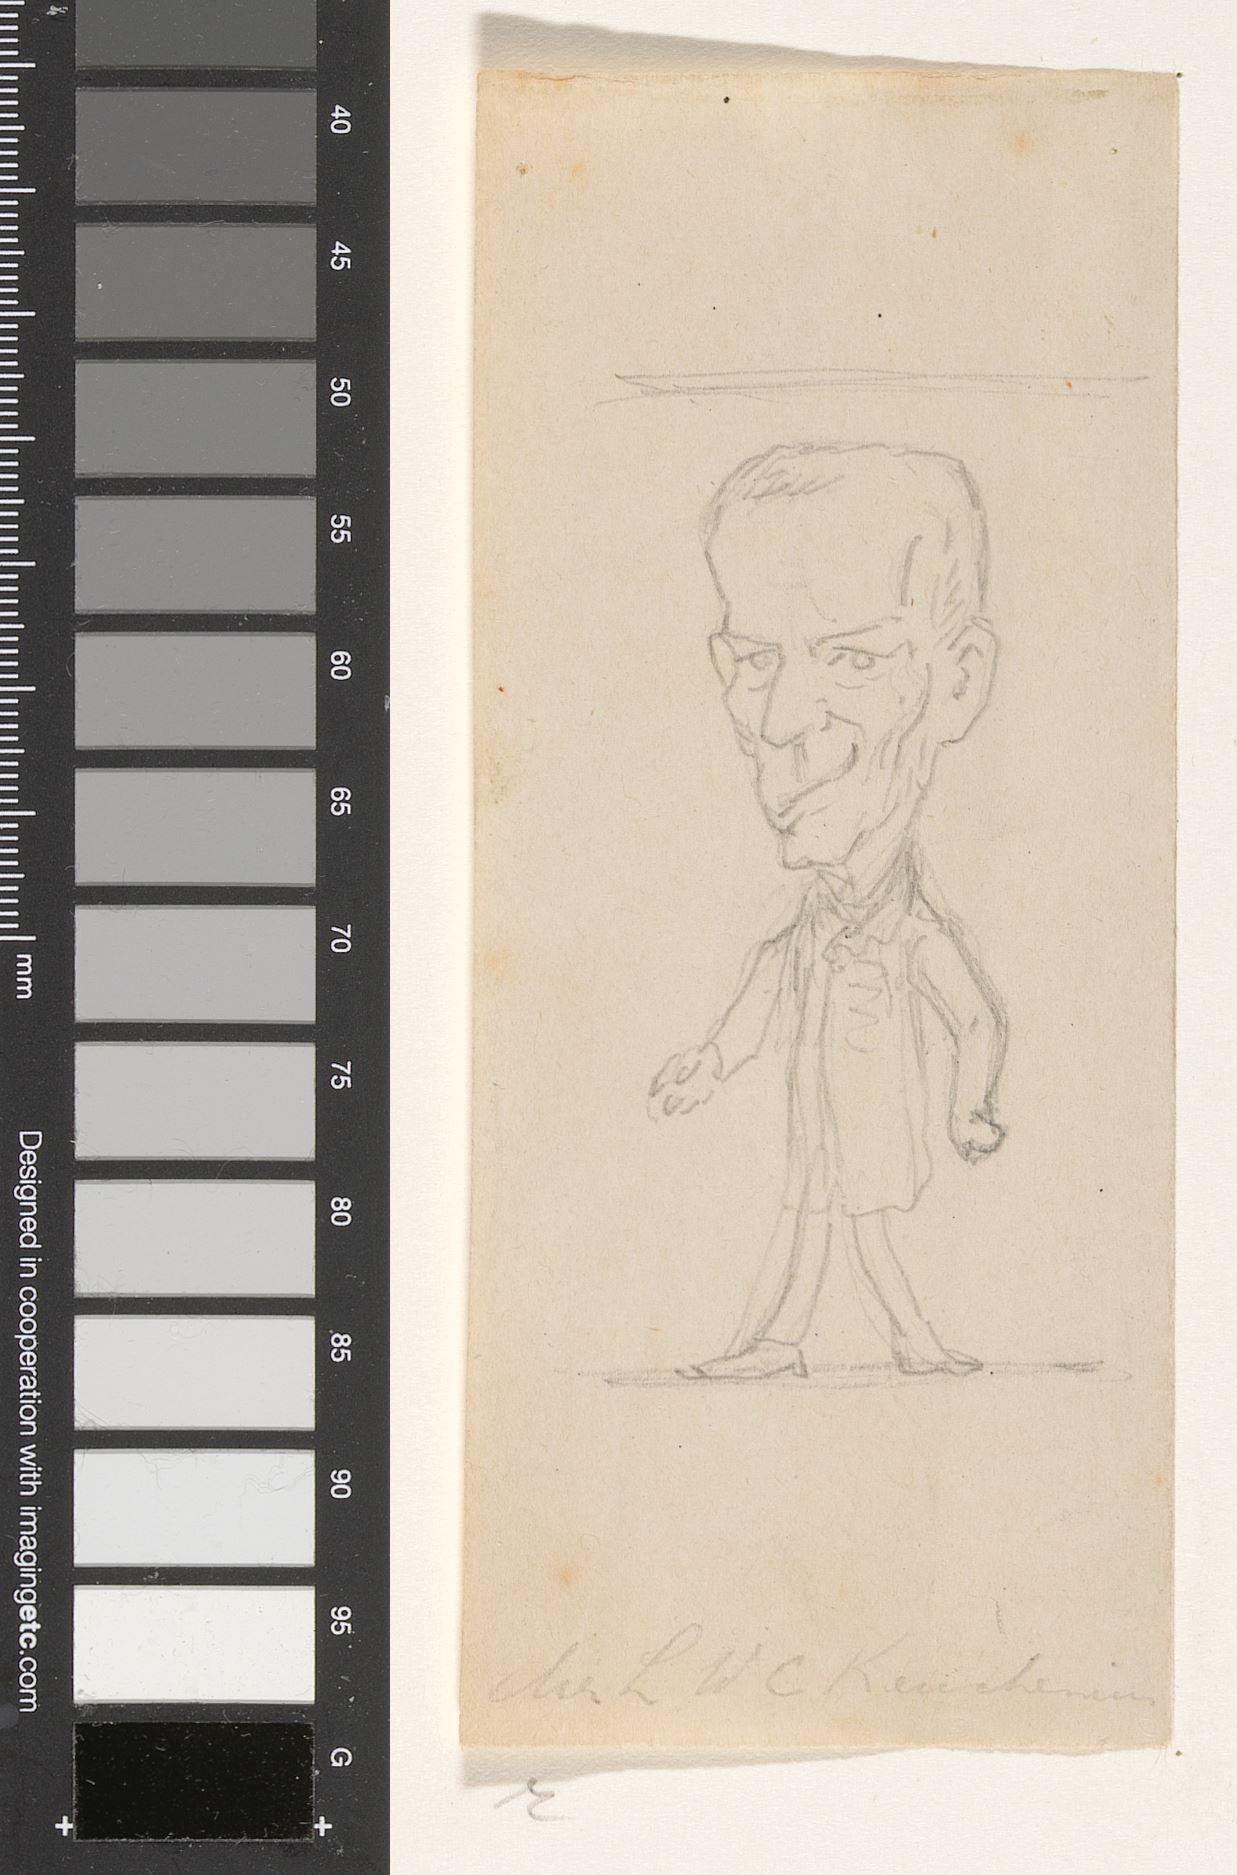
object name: drawing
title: Schets voor karikatuur van kamerlid L.W.C. Keuchenius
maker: johan michaël schmidt crans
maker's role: draughtsman, print maker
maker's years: 1830-1907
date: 1887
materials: paper, pencil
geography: netherlands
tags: batavia, historical persons, politician, e.g. party leader, political caricatures and satires, netherlands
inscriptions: inscription: ‘Mr LWC Keuchenius’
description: Schets voor karikatuur van kamerlid L.W.C. Keuchenius. Voorstudie voor een politieke spotprent in De Uilenspiegel 1887 p. 135.